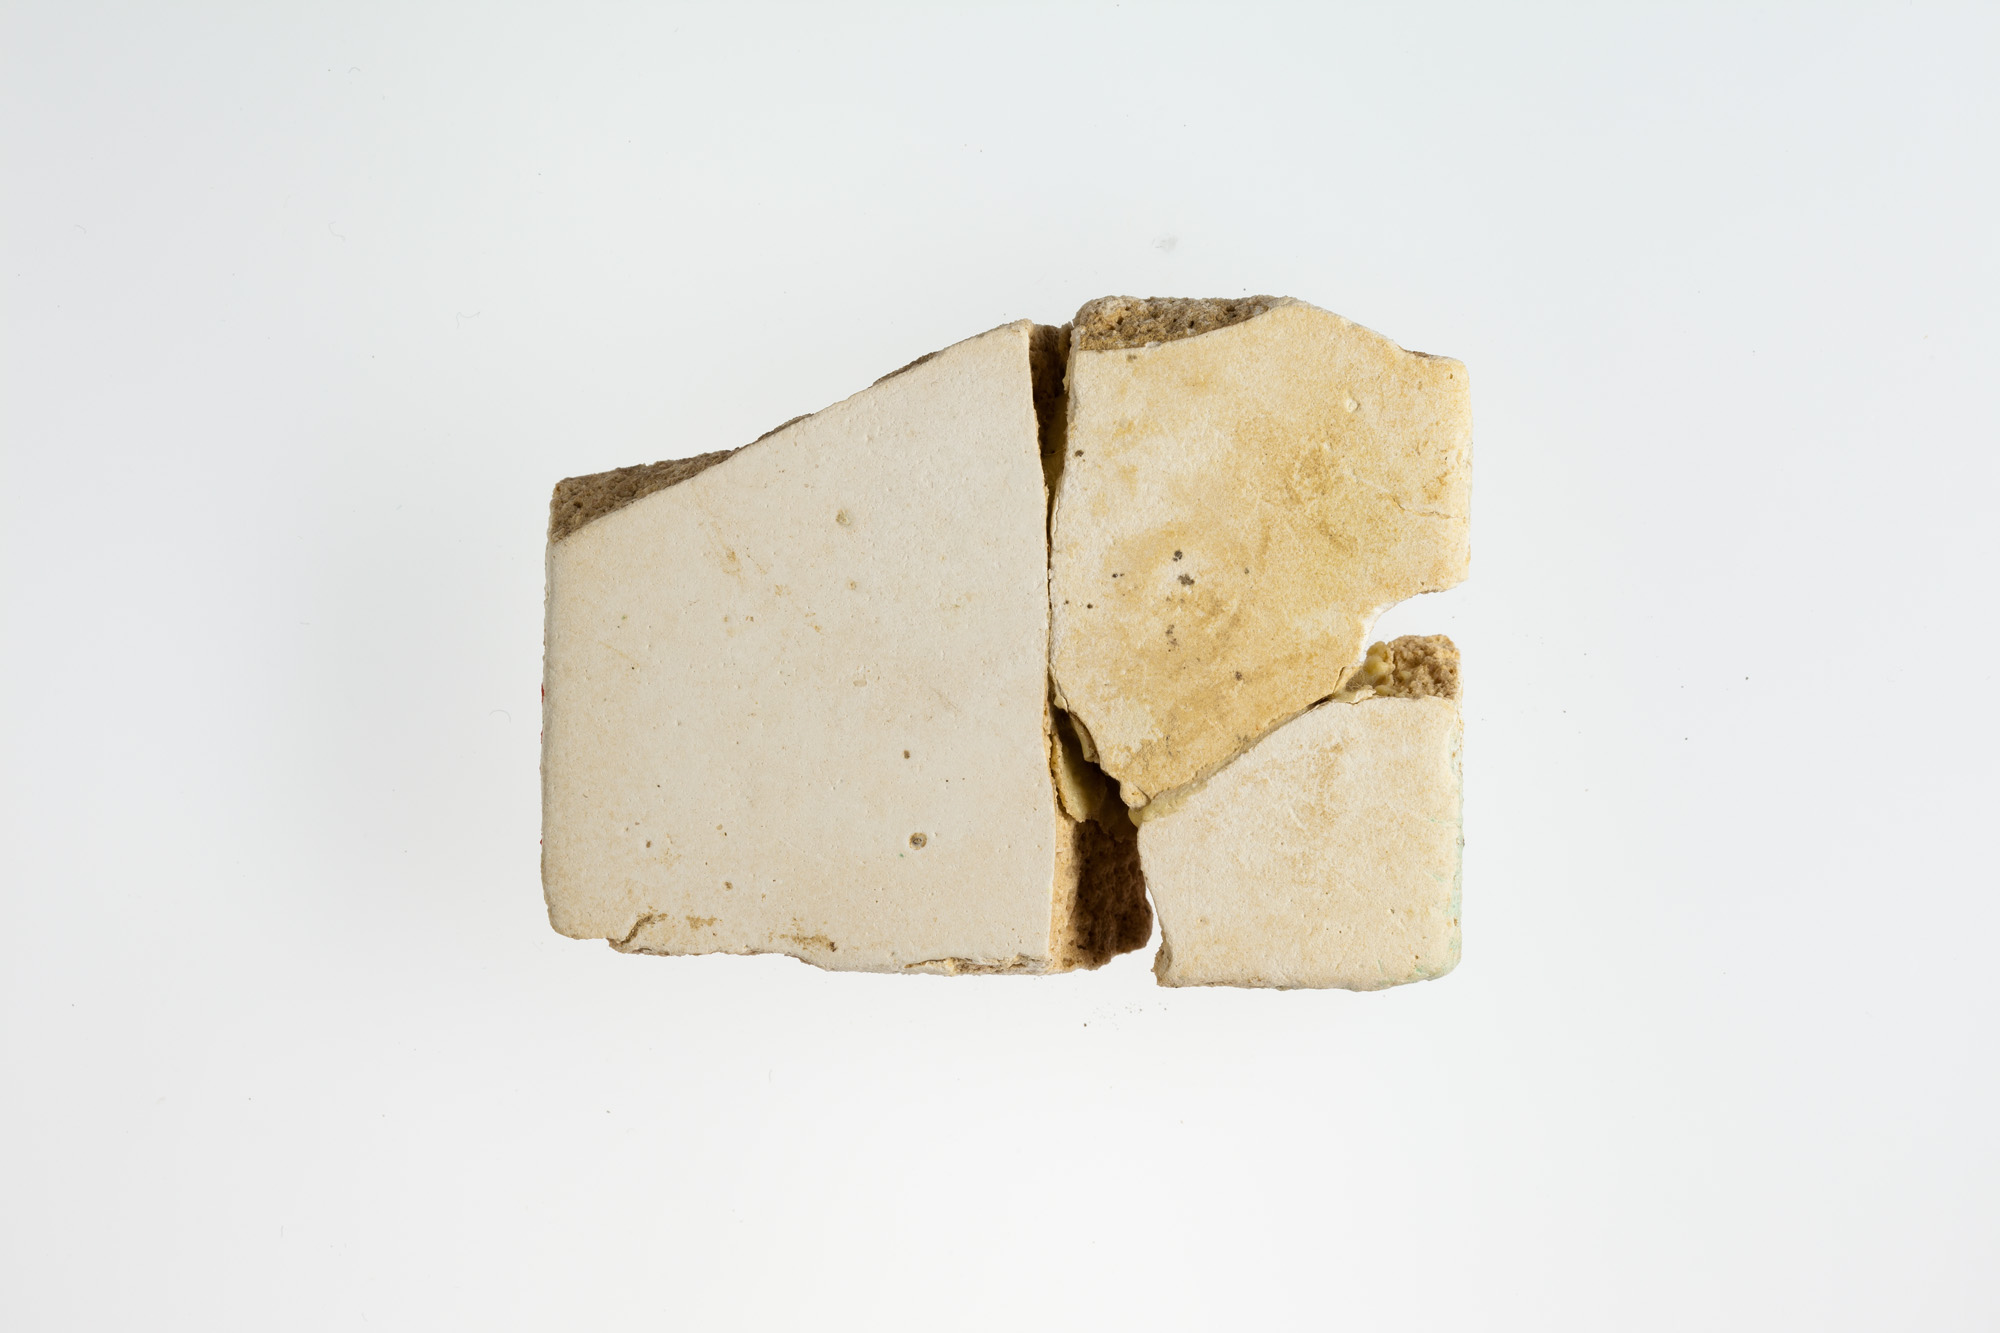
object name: tile 3 fragment joined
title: 3 tile fragments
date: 1981-1640 BCE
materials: faience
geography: egypt